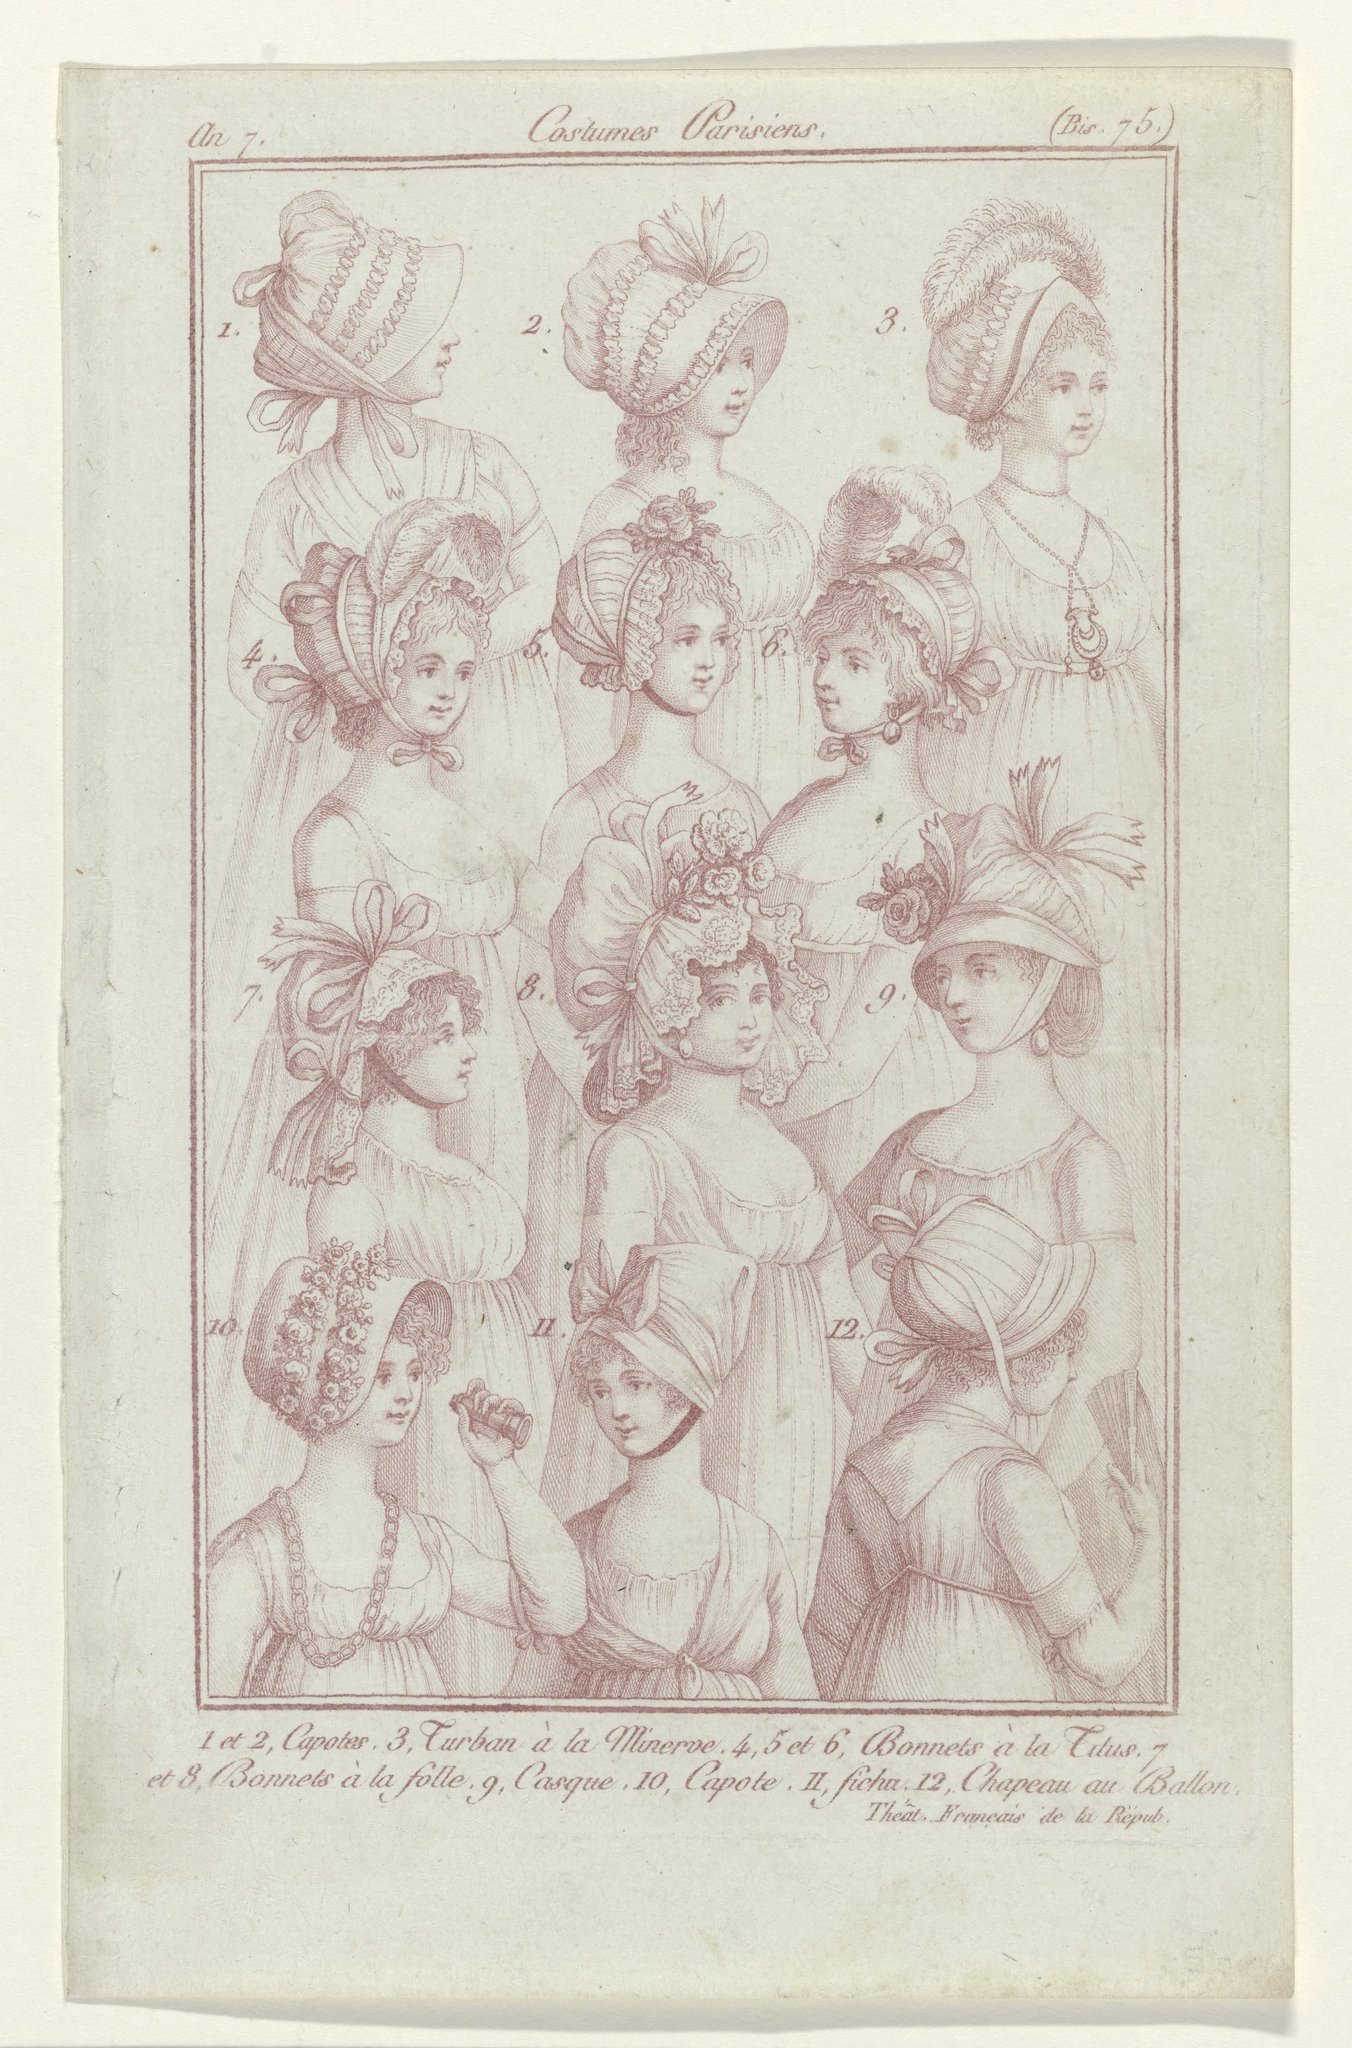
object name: fashion print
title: Journal des Dames et des Modes, Costumes Parisiens, 27 novembre 1798, An 7 (75 (bis)) : 1 et 2, Capotes. 3. Turban (...)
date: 1798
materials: paper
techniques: engraving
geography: paris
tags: head-gear: turban (+ women's clothes), head-gear (capote) (+ women's clothes), monocle, single lorgnette (+ female (human being) (not to be used where -aa- is prescribed)), head-gear: cap (+ women's clothes), fashion plates, head-gear: hat (+ women's clothes)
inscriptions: caption: ‘1 et 2, Capotes. 3. Turban à la Minerve. 4,5 et 6, Bonnets à la Titus. 7 et 8, Bonnets à la folle. 9, Casque. 10, Capote. 11, fichu. 12, Chapeau au Ballon. / Théât. Français de la Repub.’, title: ‘Costume Parisien.’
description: Twaalf vrouwenbustes met verschillende hoofddeksels: '1 et 2, Capotes. 3. Turban à la Minerve. 4,5 et 6, Bonnets à la Titus. 7 et 8, Bonnets à la folle. 9, Casque. 10, Capote. 11, fichu. 12, Chapeau au Ballon.' Volgens het onderschrift is deze voorstelling naar het leven getekend bij de 'Théat. Français de la Repub.'. De prent maakt deel uit van het modetijdschrift Journal des Dames et des Modes, uitgegeven door Sellèque, Parijs, 1797-1839.